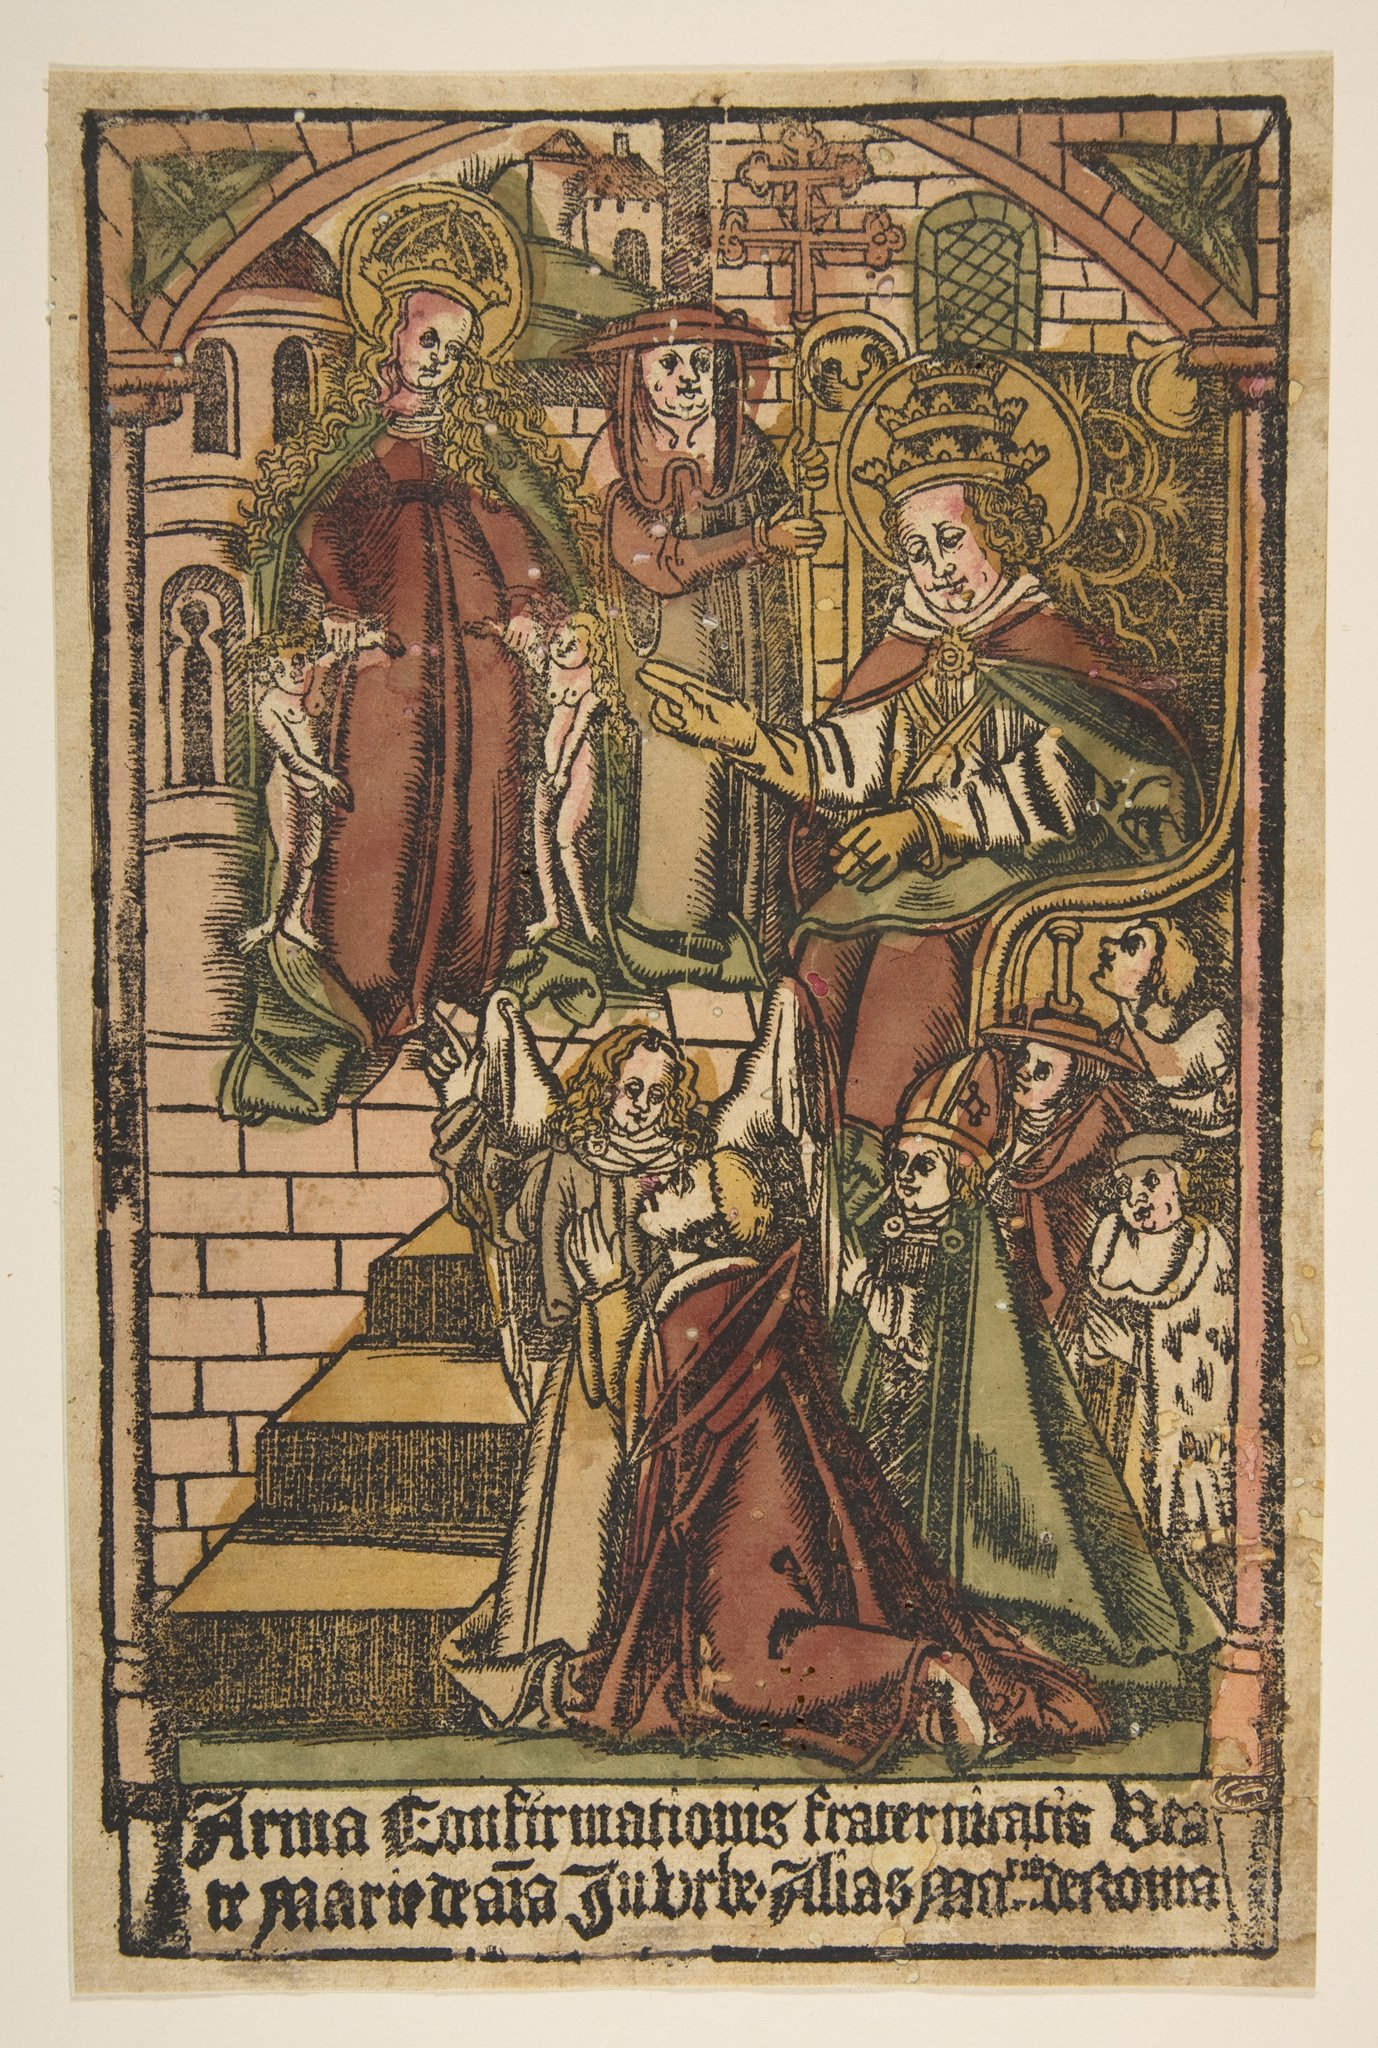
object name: print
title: Santa Maria dell'Anima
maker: anonymous, german, 15th century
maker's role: artist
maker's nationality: german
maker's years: 1400-1500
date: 1401-1500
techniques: hand coloring, woodcut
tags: men,women